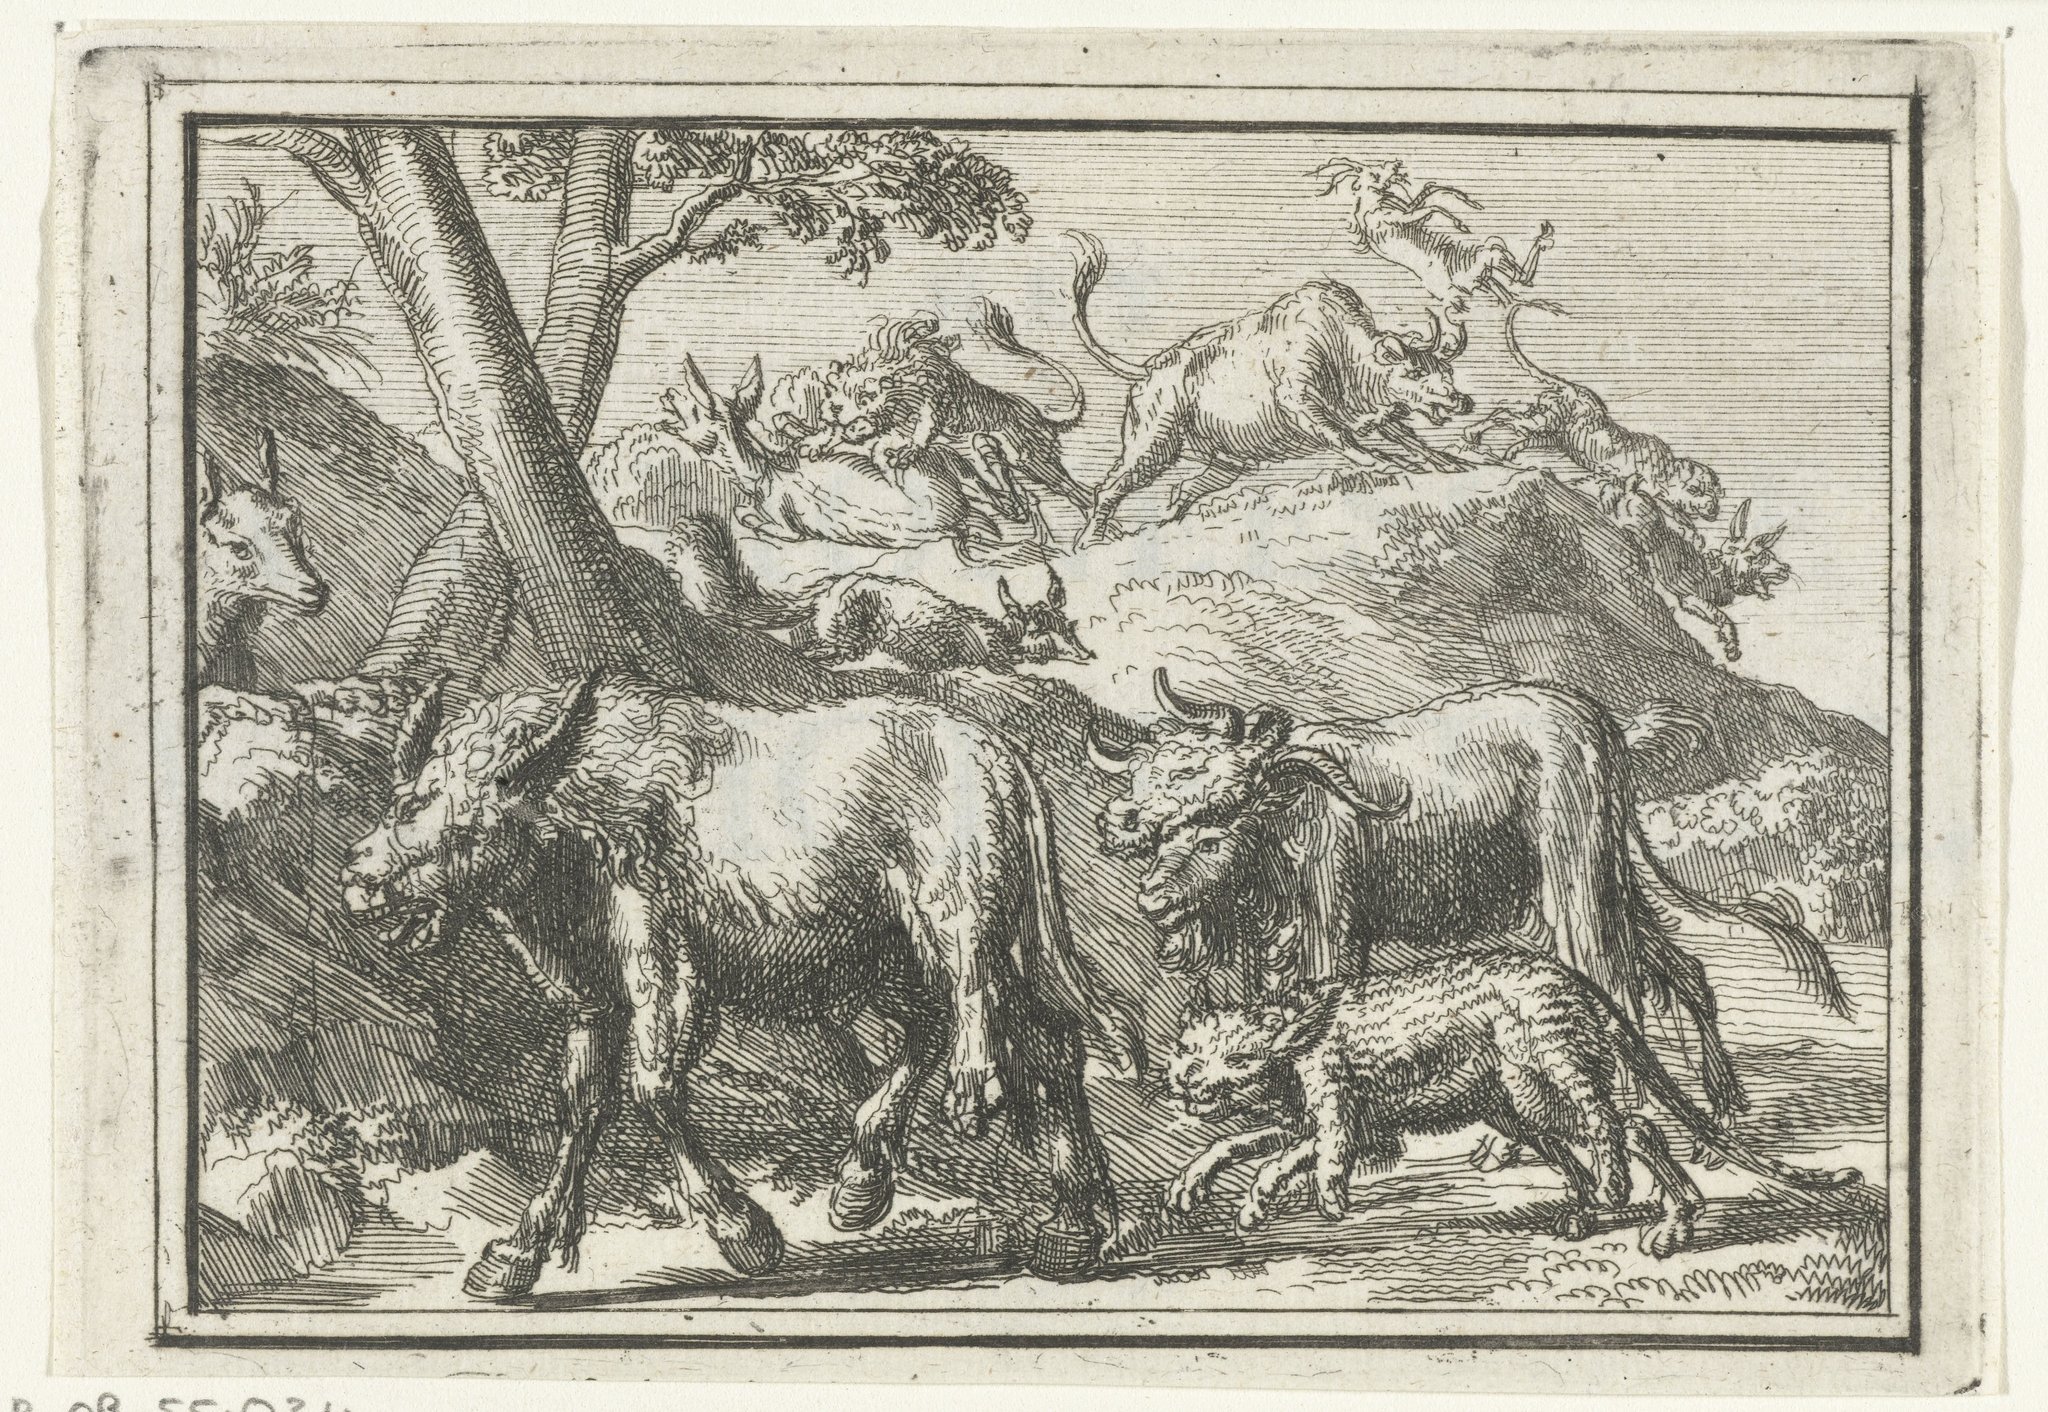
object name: print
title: Esopus in Europa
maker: romeyn de hooghe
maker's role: draughtsman, goldsmith, painter, print maker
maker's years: 1645-1708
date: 1702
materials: paper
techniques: engraving, etching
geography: netherlands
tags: spaanse successieoorlog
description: Fabel van de ezel die zich met de huid van een leeuw onherkenbaar maakt, een geit met de huid van een buffel en een haas met de huid van een kat. De dieren (Fransen) worden door de vos herkend en verraden en, op de achtergrond, door de echte dieren (de Geallieerden) verscheurd. Titel staat op apart tekstblad.